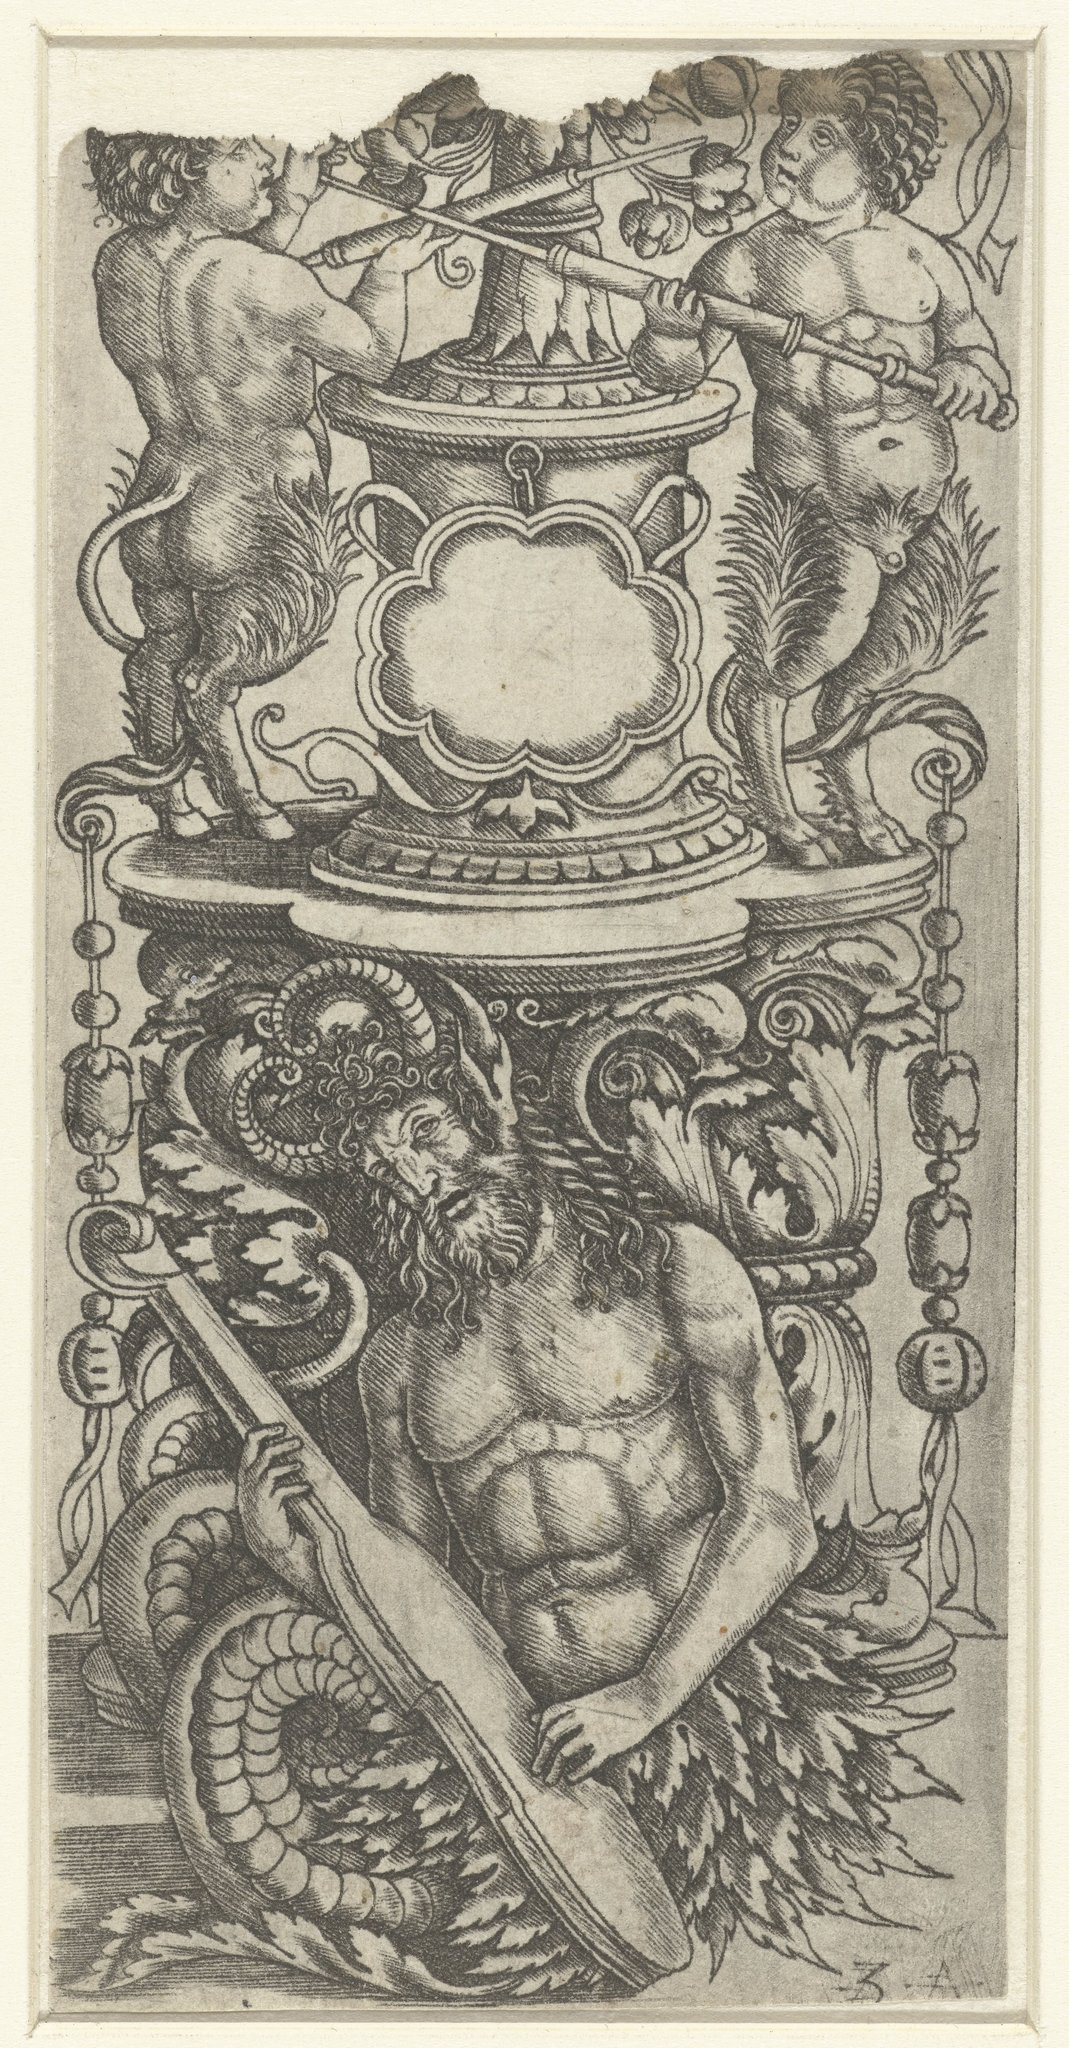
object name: print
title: Fragment van kandelaber-ornament met triton en twee satyr kinderen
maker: zoan andrea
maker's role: draughtsman, print maker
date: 1500-1505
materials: paper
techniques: engraving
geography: italy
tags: triton(s), satyr(s) (in general)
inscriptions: collector's mark: Lugt 2228, collector's mark: Lugt 2760